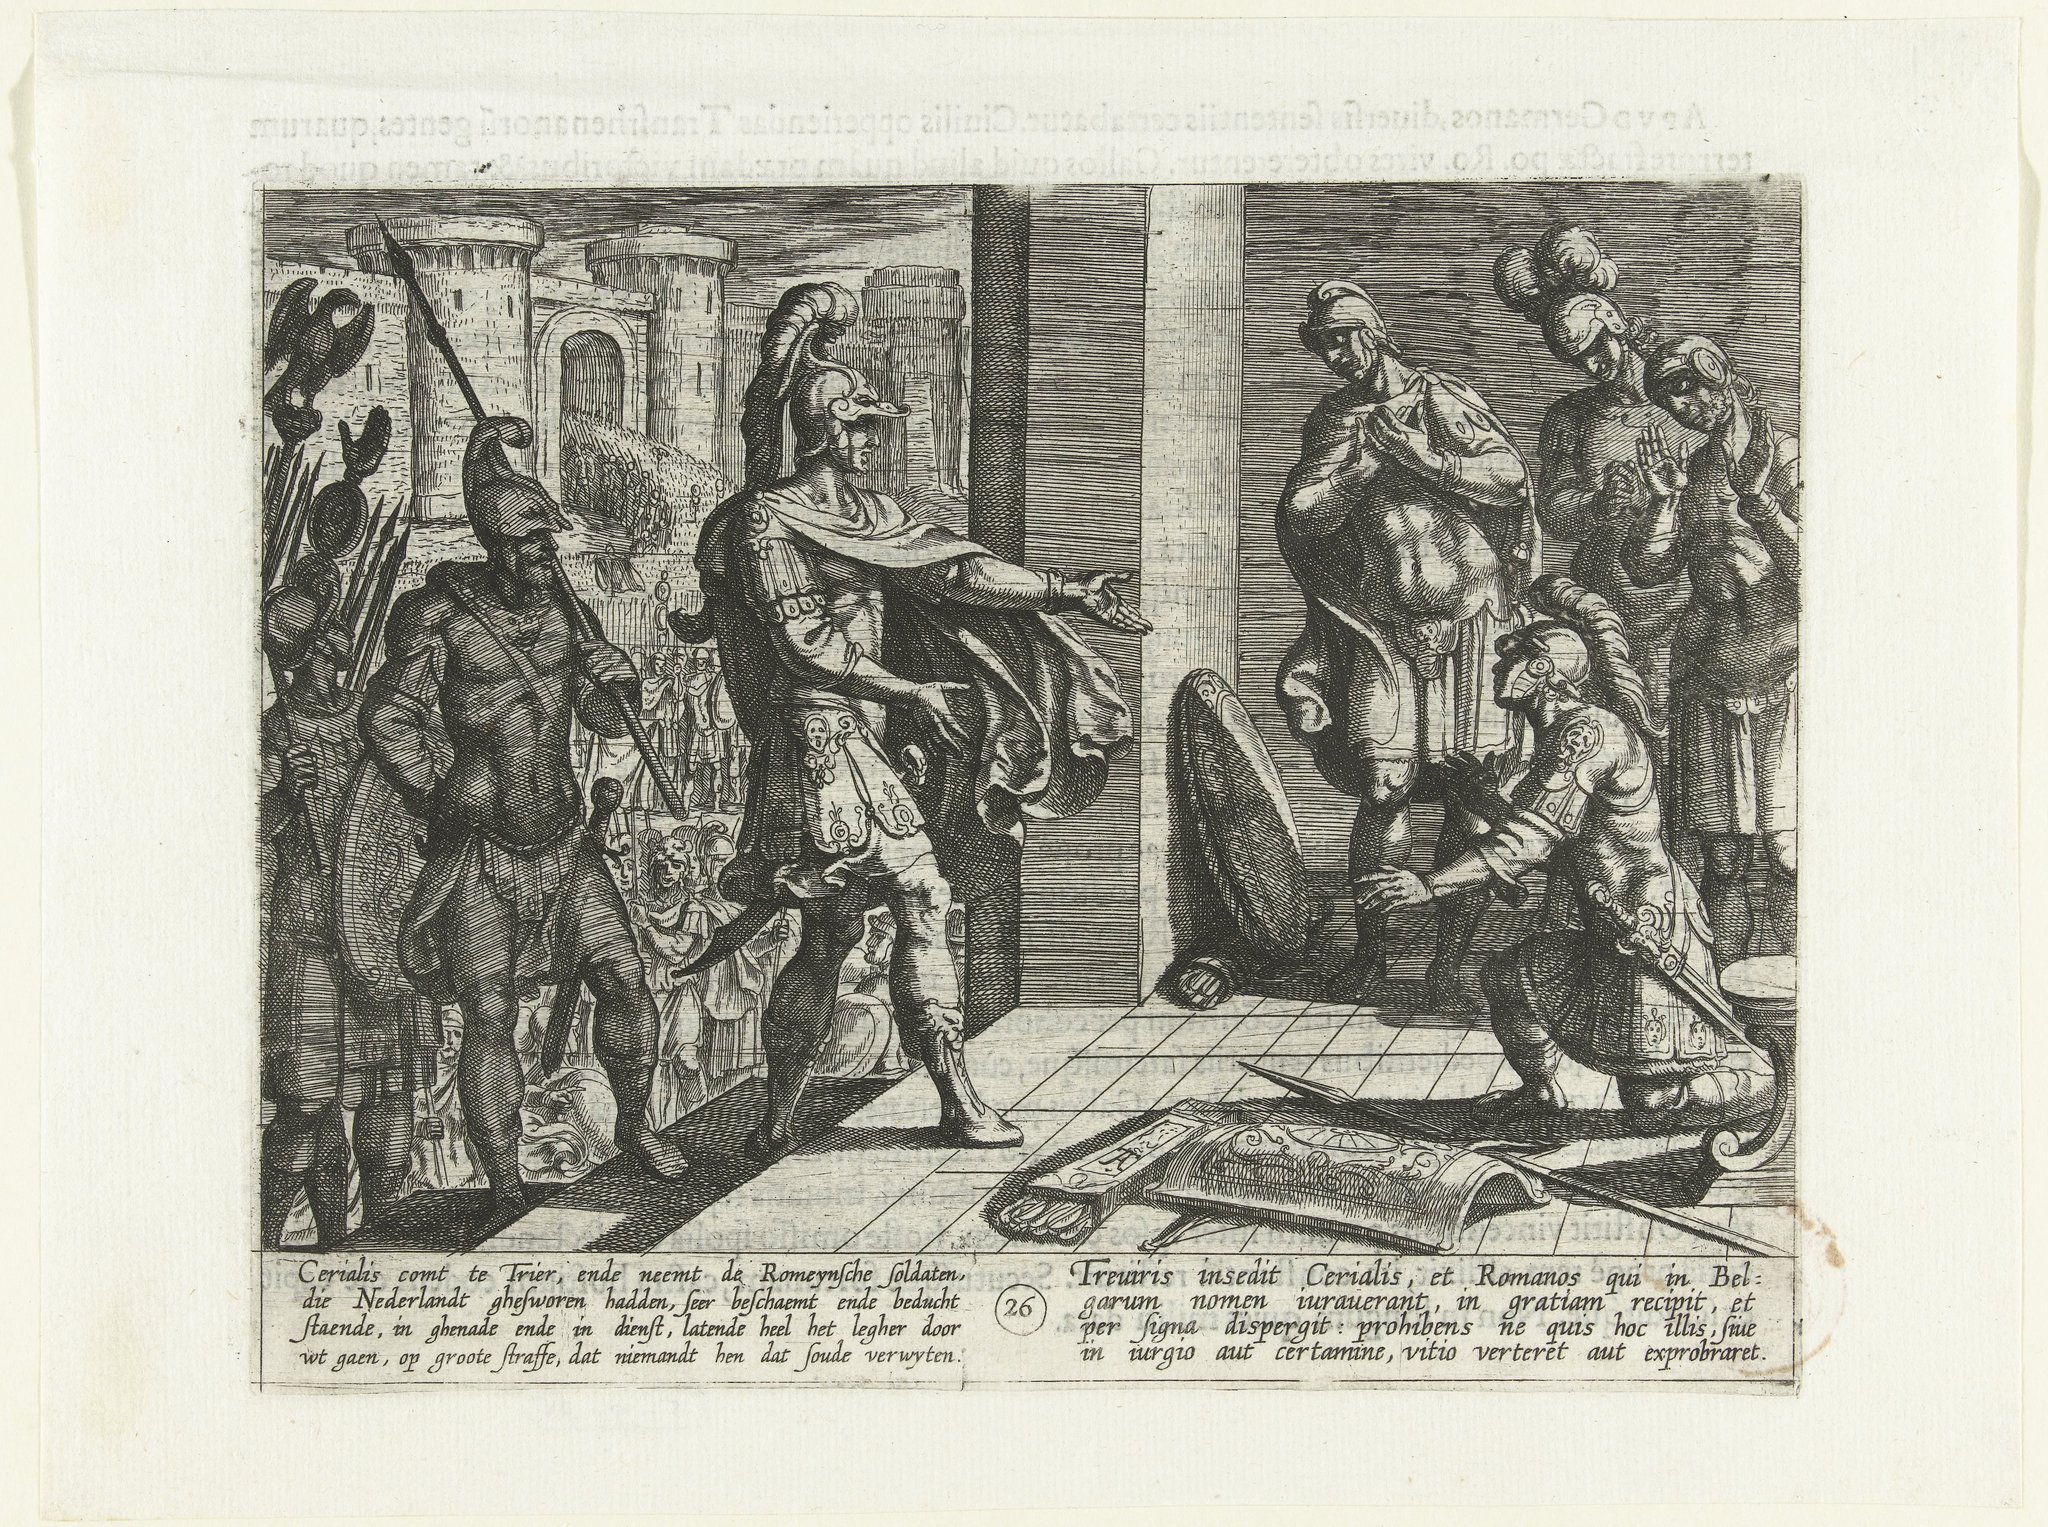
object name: print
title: De Bataafse Opstand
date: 1612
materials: paper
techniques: etching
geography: italy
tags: granting mercy; free pardon, extinct, 'historical' peoples (with name), netherlands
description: Cerialis schenkt overgelopen Romeinse soldaten genade. Prent nummer 26 in de serie prenten over de Bataafse Opstand: Batavorum cum Romanis bellum / à Corn. Tacito lib. IV & V. : Hist. olim descriptum, figuris nunc aeneis expressum, auctore Othone Vaenio Lugdunobatava = De Batavische oft oude Hollandtsche oorloghe teghen de Romeynen. Otto Vaenius, Antwerpen 1612. Onderaan twee verzen van vier regels in het Nederlands en in het Latijn. Op de achterzijde tekst in het Latijn.